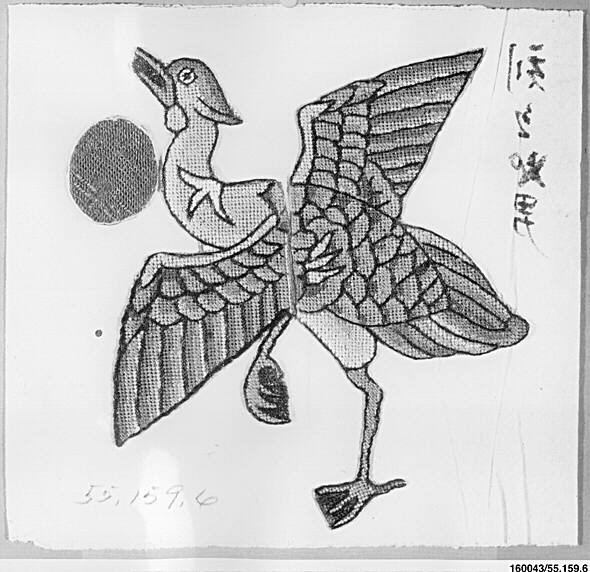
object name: appliqué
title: Applique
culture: chinese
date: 1867-1933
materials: metal thread, silk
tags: birds